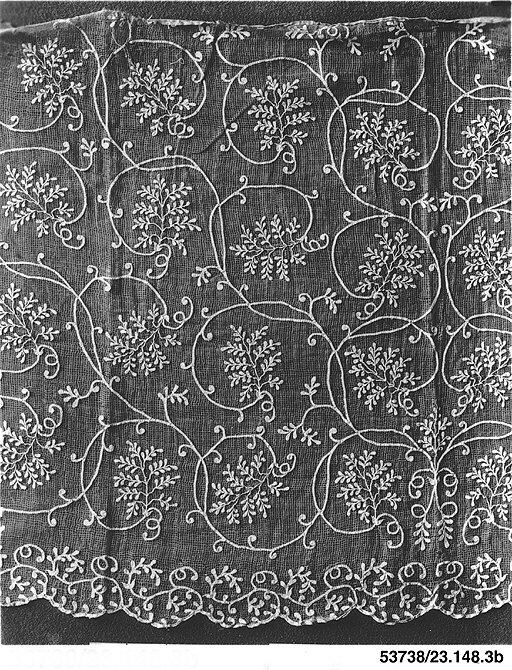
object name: sleeve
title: Bodice sleeve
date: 1801-1850